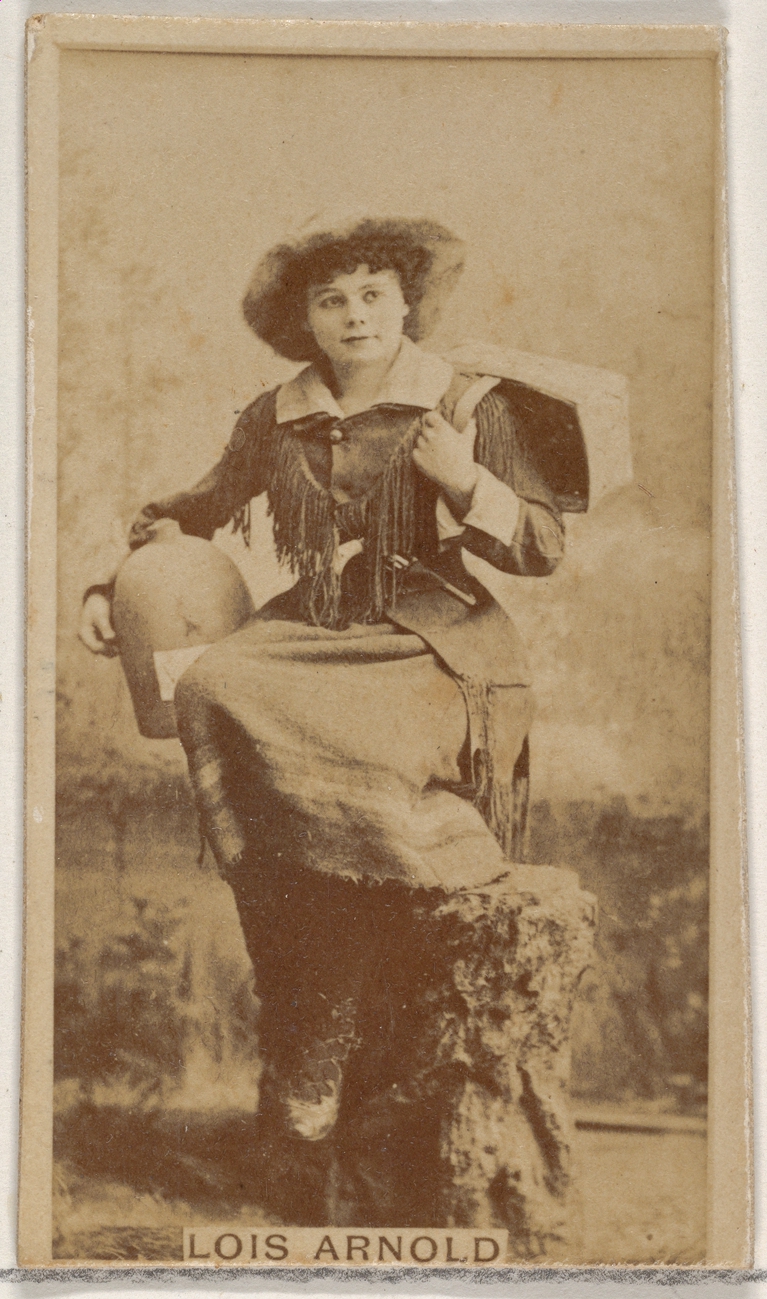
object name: photograph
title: Lois Arnold, from the Actors and Actresses series (N45, Type 8) for Virginia Brights Cigarettes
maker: allen & ginter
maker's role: publisher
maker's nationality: american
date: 1888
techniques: albumen silver print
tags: portraits,women,actresses